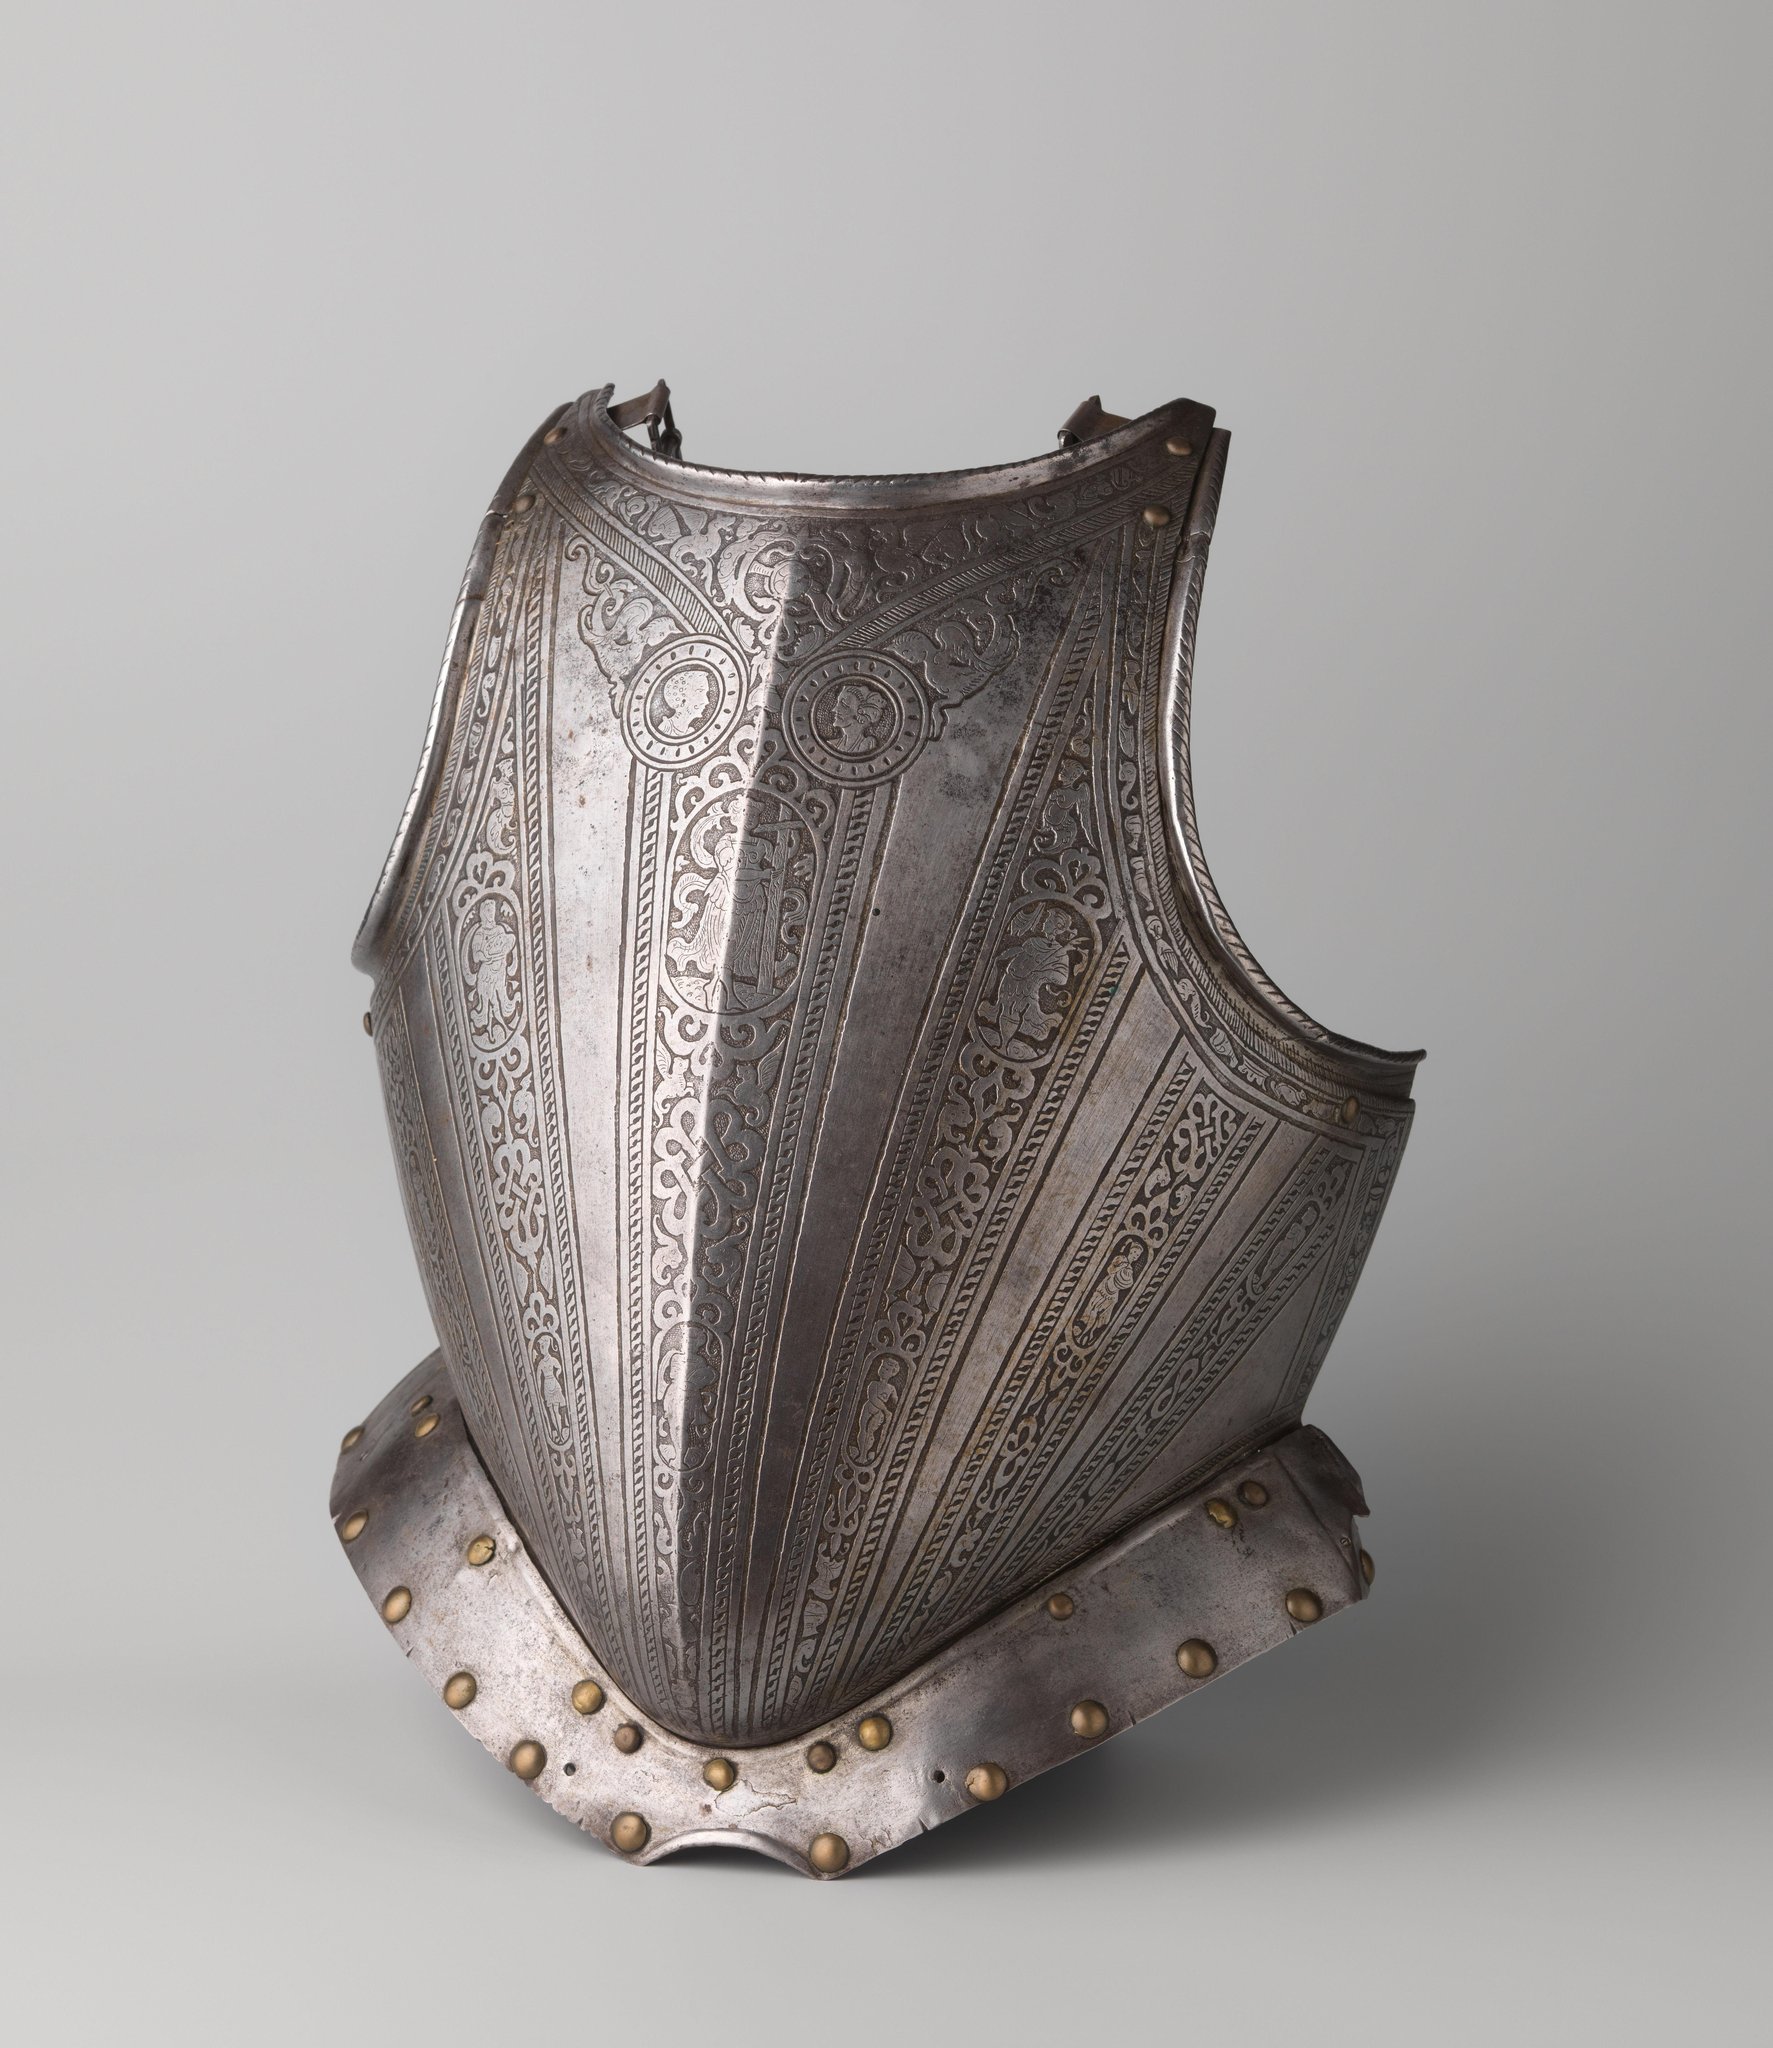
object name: breastplate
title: Borstplaat van een harnas met versieringen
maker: Anonymous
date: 1525-1575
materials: copper, metal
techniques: etching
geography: europe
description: Borstplaat, ijzer, blank, uit drie delen gemaakt, de randen van de hals- en armuitsnijdingen zijn bekabeld, rondgeflenst en aan de binnenkant van de borstplaat geklonken. Aan weerzijden van de van de halsuitsnijding onder de rand aangeklonken ijzeren gespen. Rechte middengraat die eindigt in een kleine uitstulping boven de buikkraag. Onder de randen van de borstplaat is een versieringen te zien van verschillende vormen en dieren. Behalve de middengraat nog zes parallel lopende stroken die versierd zijn met diverse, vermoedelijk, bijbelse figuren. Onder de halsuitsnijding versieringen van een rond figuur die door twee engelen met aan weerzijden verschillende dieren. In het midden twee cirkels waarin het hoofd van een man en het hoofd van een vrouw worden afgebeeld. De cirkels worden gedragen door twee engelen figuren. Hieronder is een vrouw figuur te zien die een kruis vasthoudt met beide handen. Op de strook links van deze ets een figuur die een schaal vast heeft waar een hoofd op ligt. Rechts een vrouw figuur die haar rok licht omhoog trekt. Kleinere figuren staan op de overige stroken. De buikkraag is aan de borstplaat geklonken met geelkoperen klinknagels, de randen zijn licht verbogen. De binnenkant is zwart geverfd.